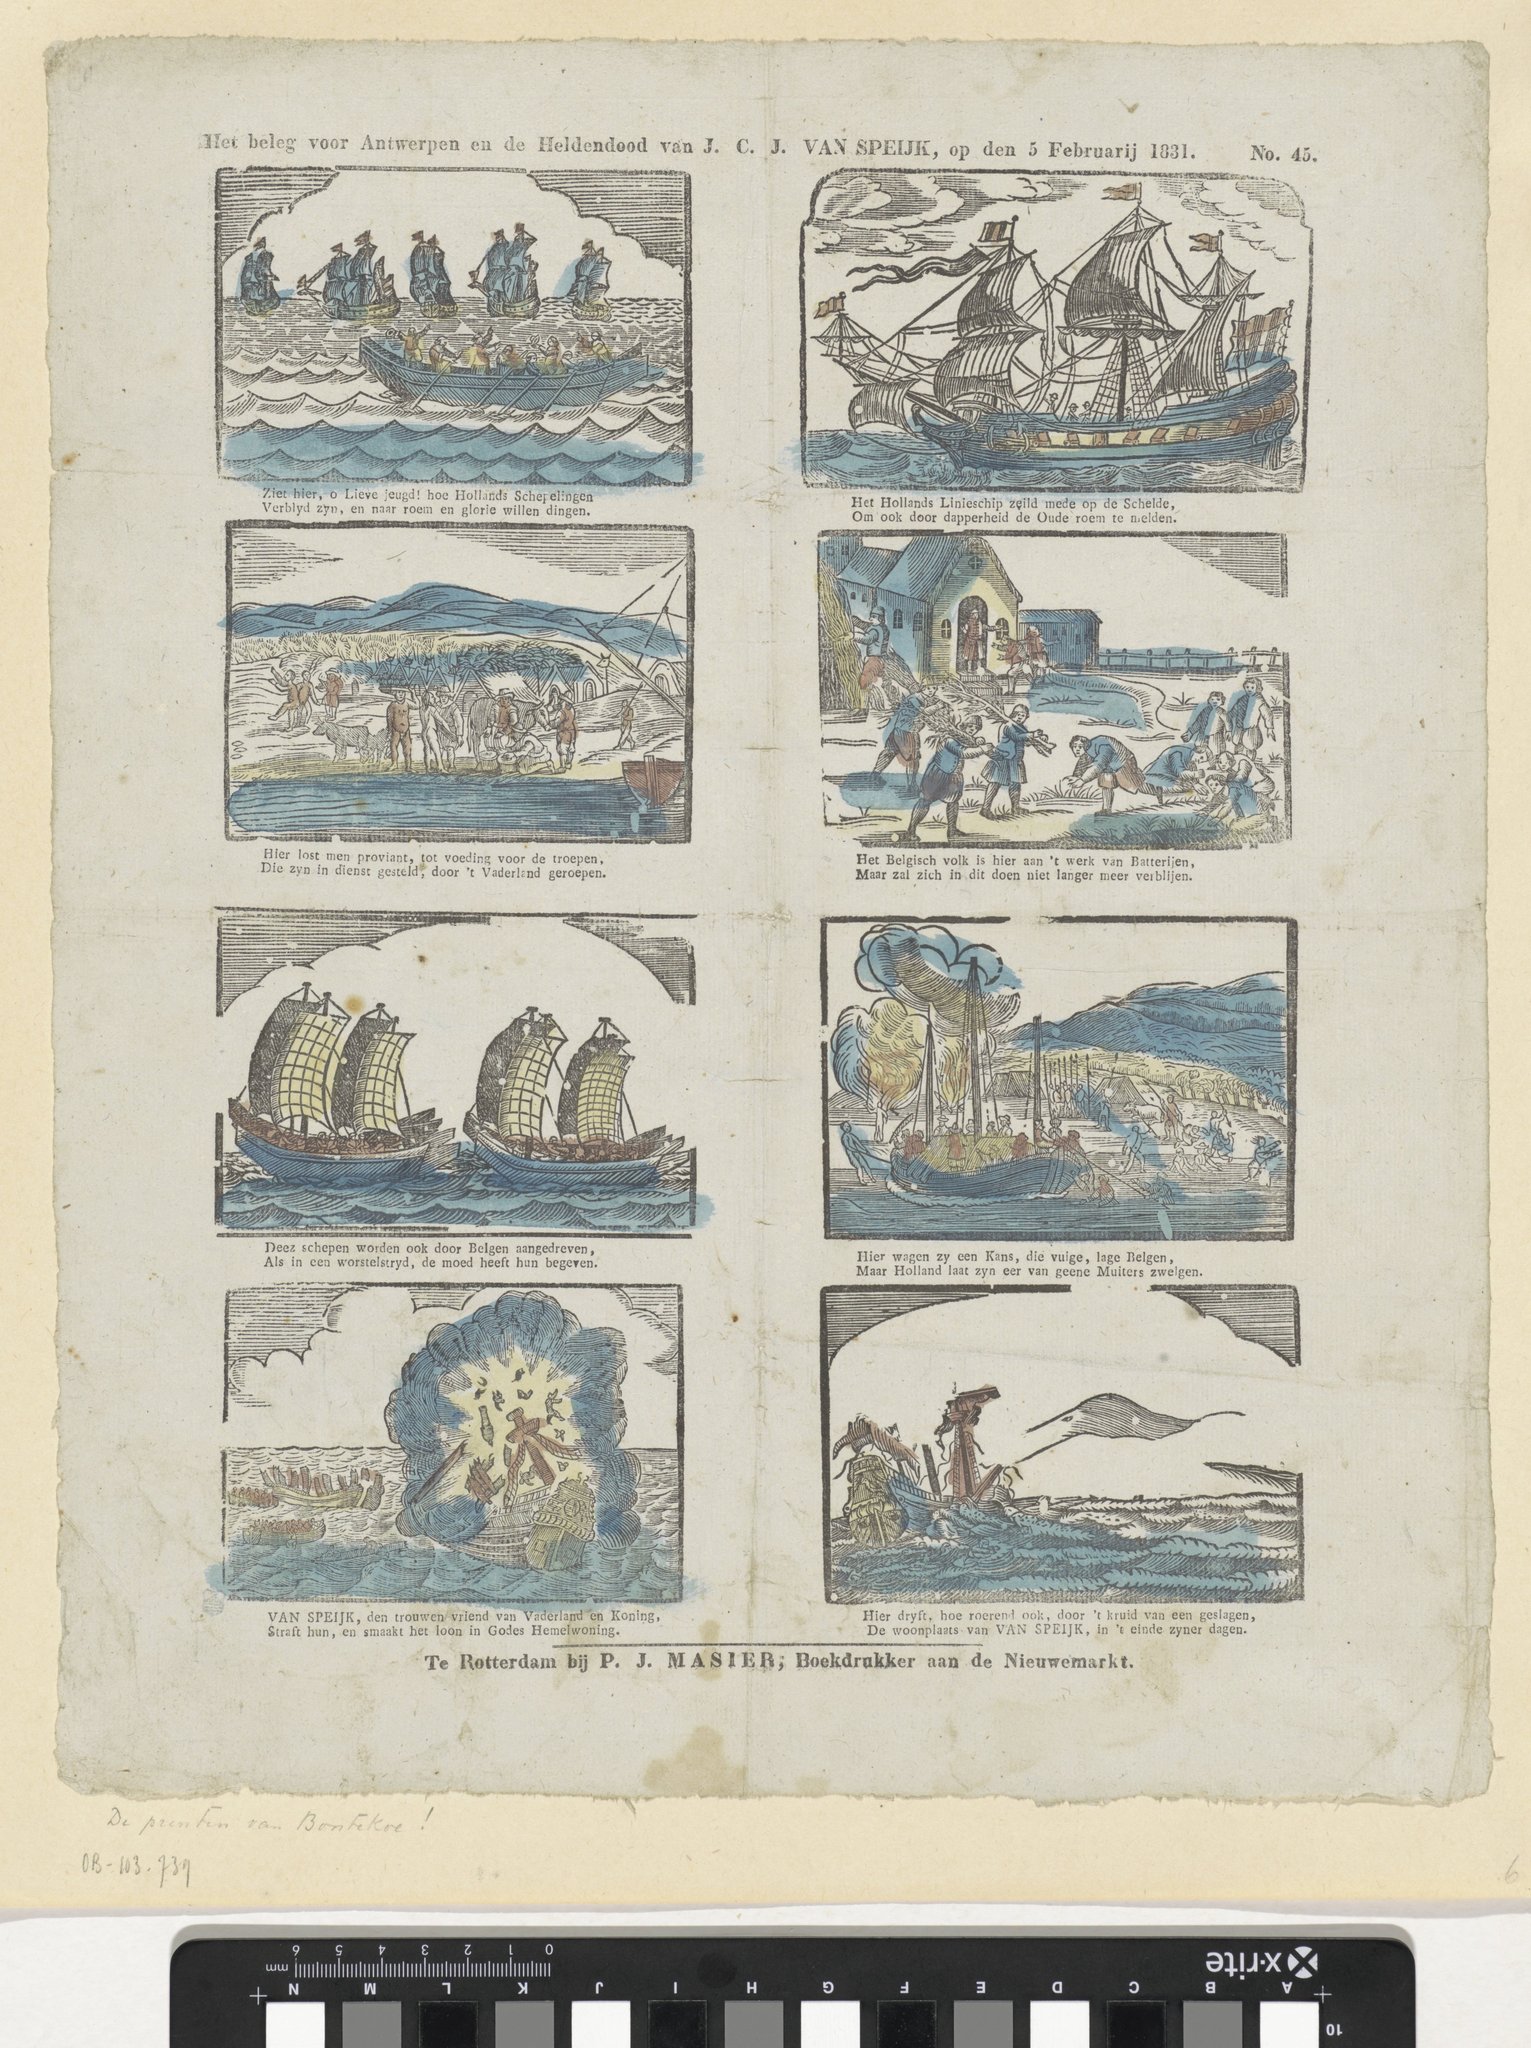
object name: print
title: Het beleg voor Antwerpen en de heldendood van J. C. J. Van Speijk, op den 5 februarij 1831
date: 1827-1860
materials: paper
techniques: colour, letterpress printing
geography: rotterdam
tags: amsterdam, antwerp, jan van speyk, mutiny, rebellion ~ military discipline, battle, ships (in general), revolution, revolt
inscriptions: collector's mark: Lugt 2760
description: Blad met 8 voorstellingen over de Belgische Revolutie, waaronder het beleg van Antwerpen en de zelfopoffering van J.C.J. van Speyk. Onder elke afbeelding een tweeregelig vers. Genummerd rechtsboven: No. 45.